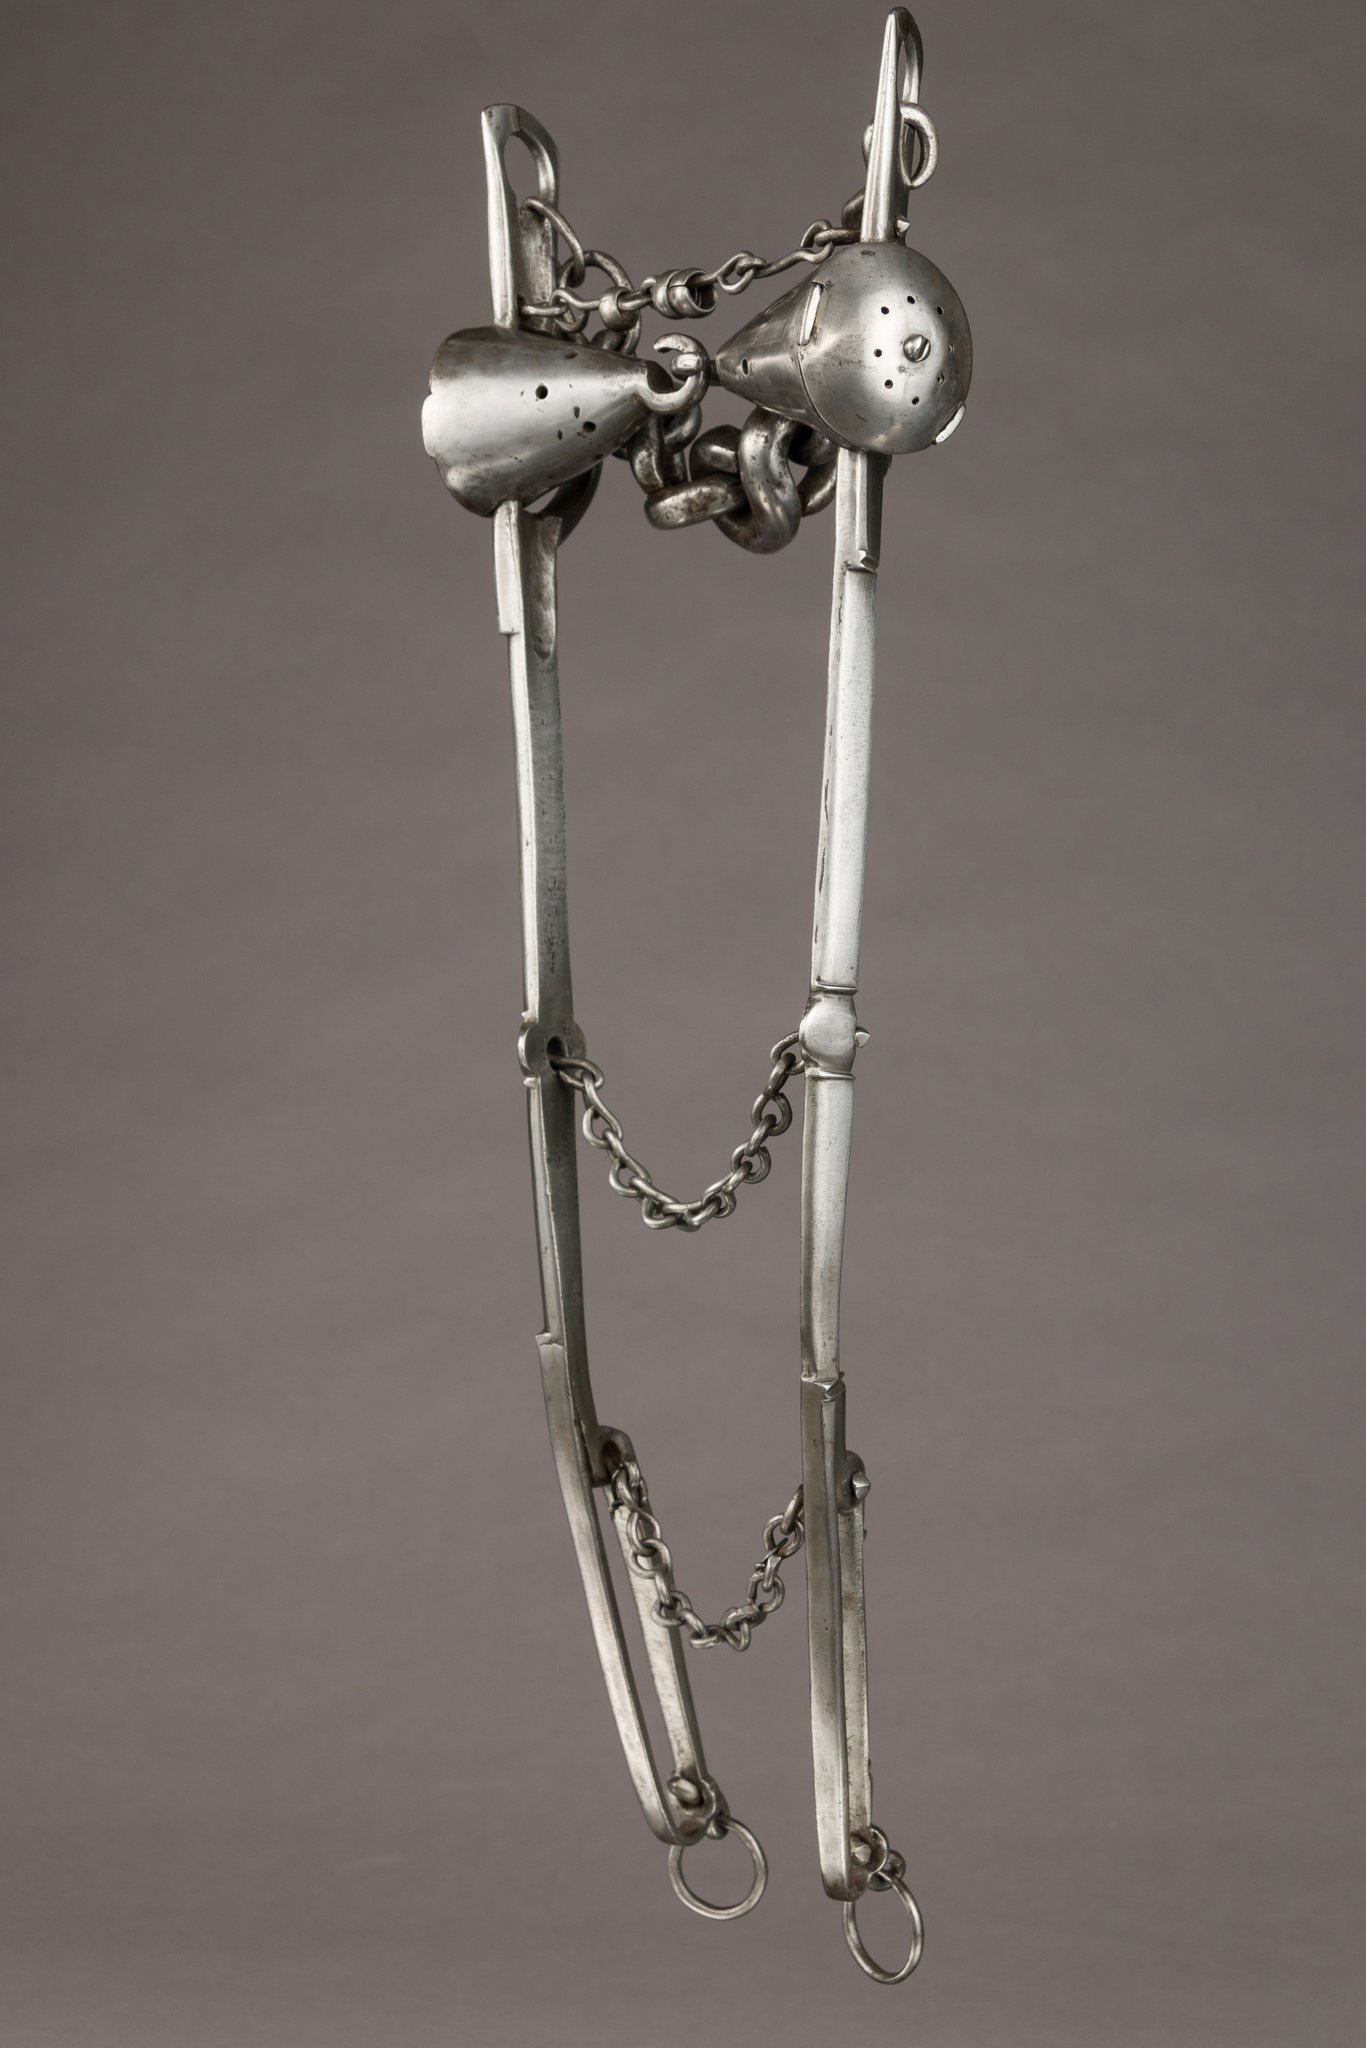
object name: bit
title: Curb Bit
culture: german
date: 1601-1633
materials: metal alloy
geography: germany